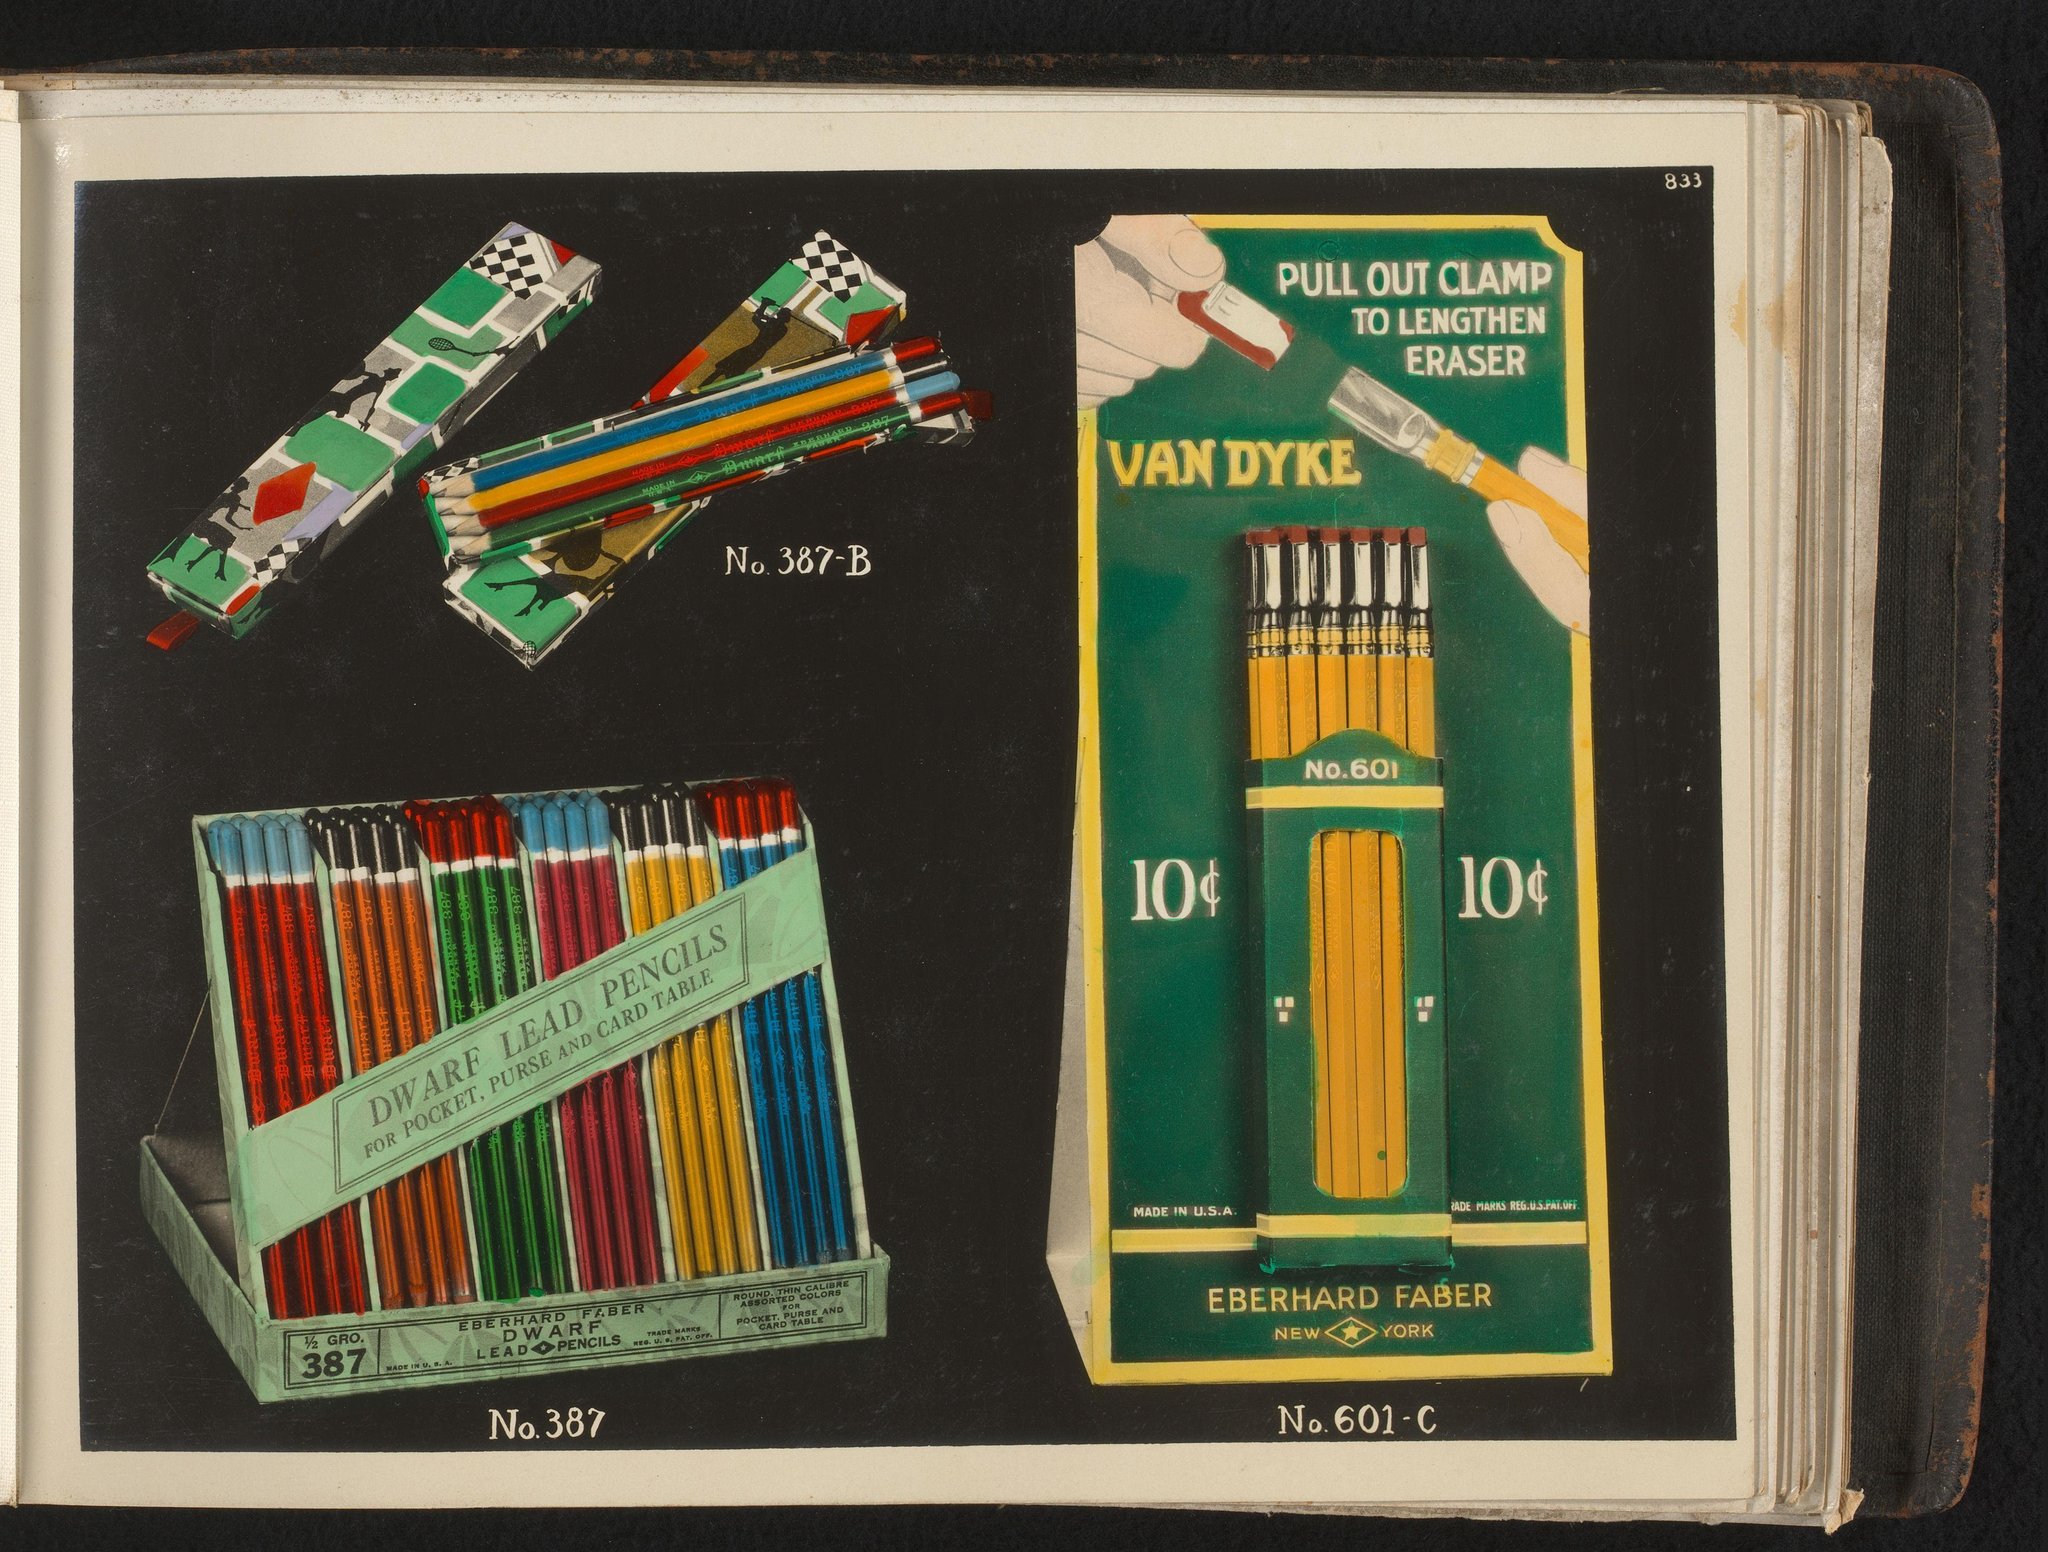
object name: album leaf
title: Sets met potloden van Eberhard Faber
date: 1915-1935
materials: paper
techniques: gelatin silver print, hand coloring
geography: springfield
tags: pencil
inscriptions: stamp: ‘Paramount/ Commercial Studios/ 145 Chestnut St./ Springfield - Mass.’, number: ‘833’